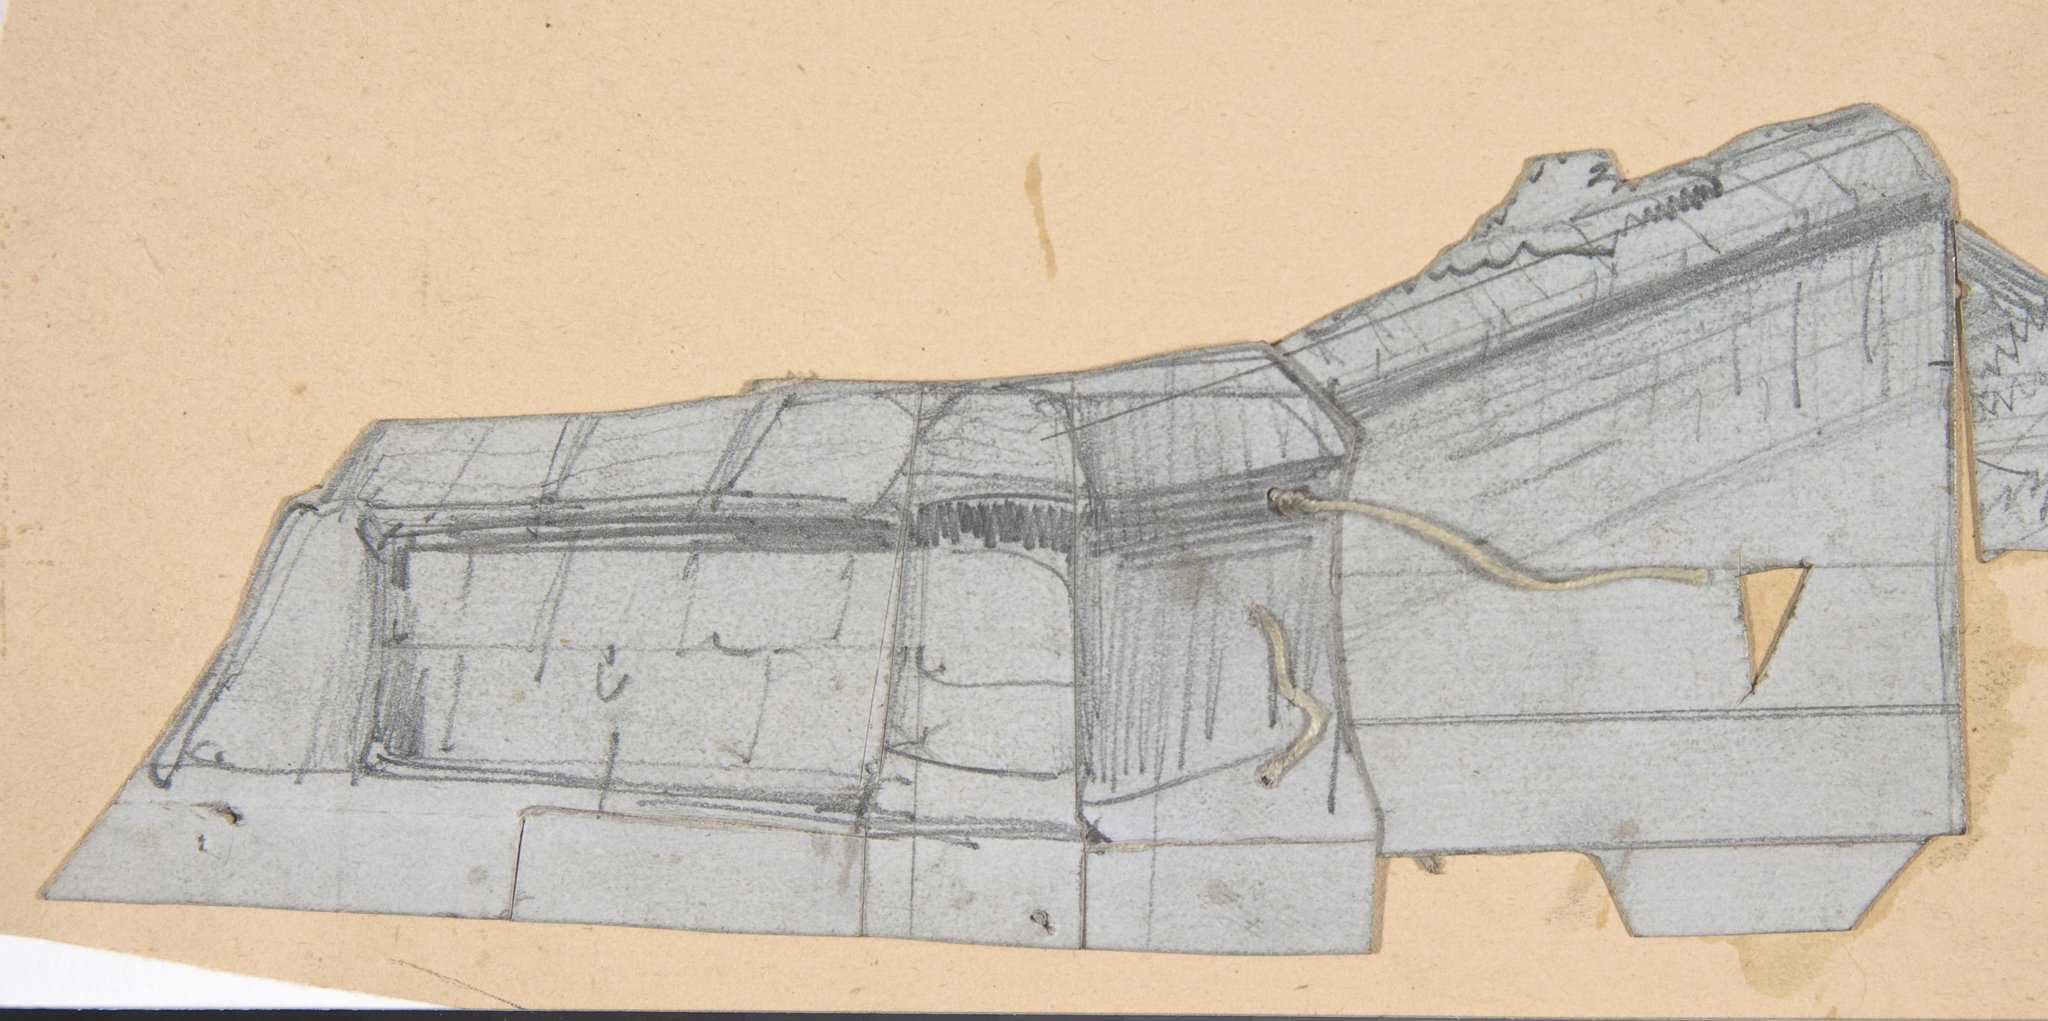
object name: drawing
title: Design for a Stage Set at the Opéra, Paris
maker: eugène cicéri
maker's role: artist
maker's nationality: french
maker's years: 1813-1890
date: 1830-1890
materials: graphite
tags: stage design